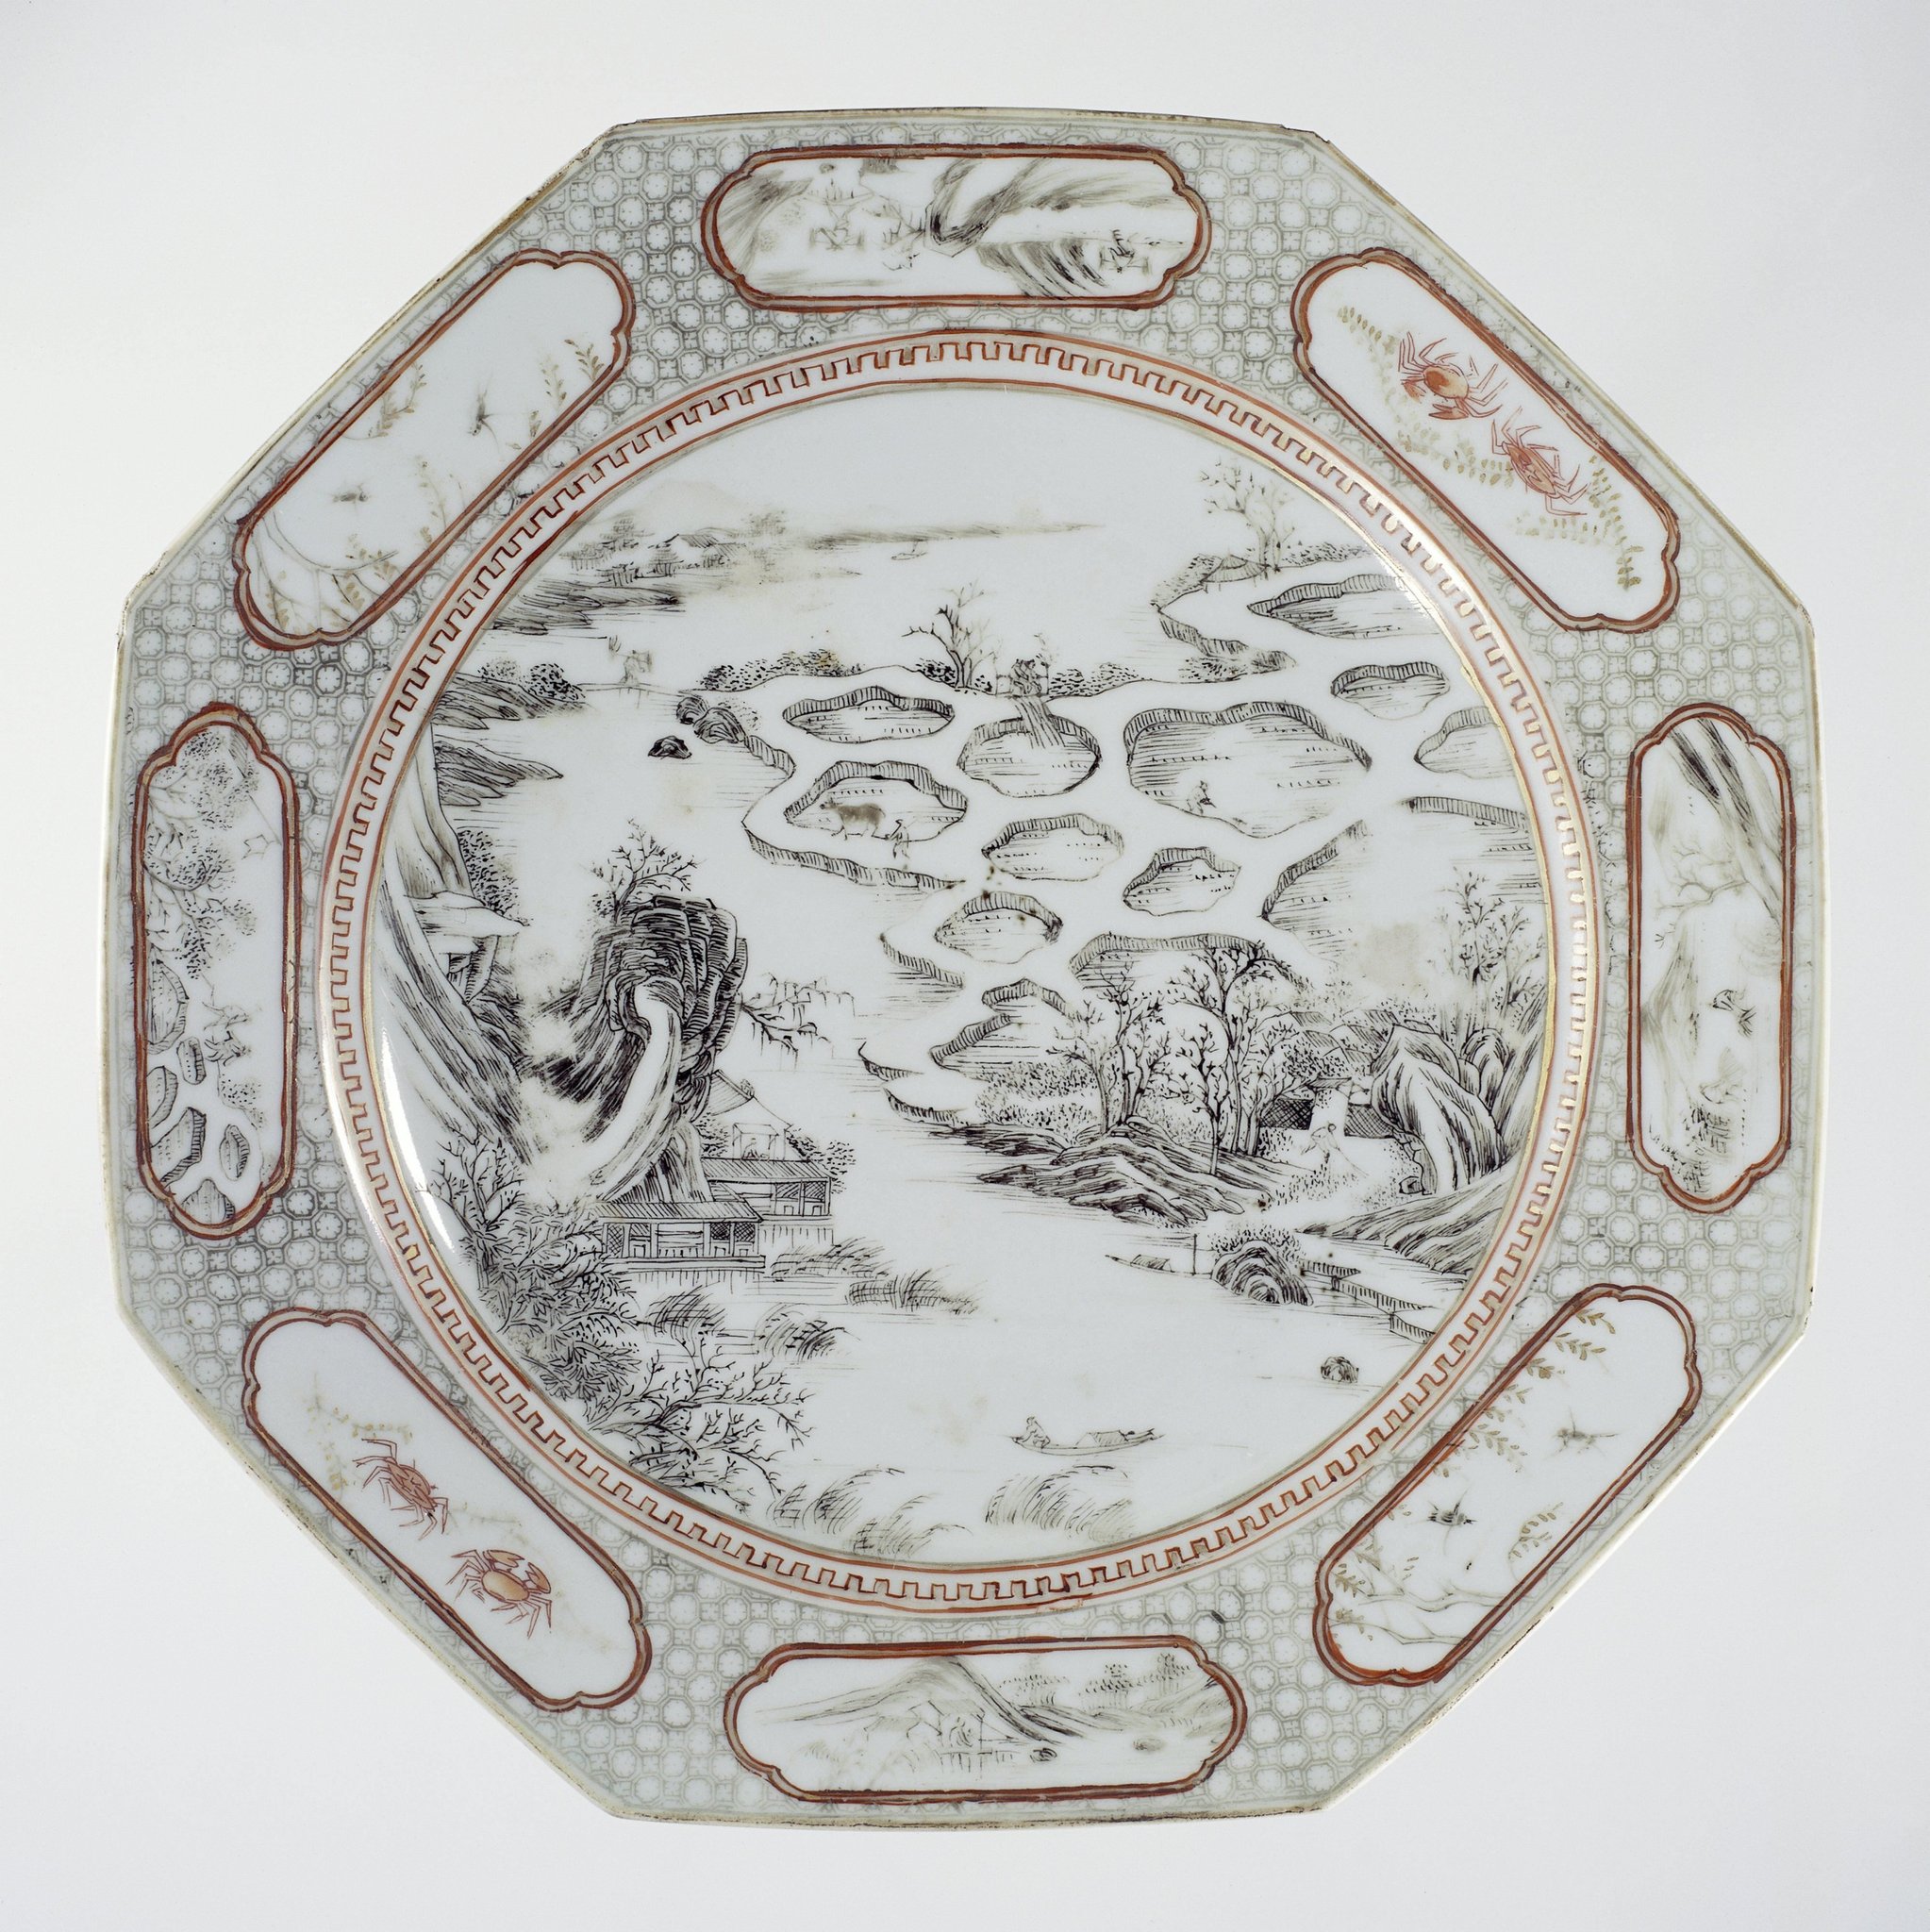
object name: plate dish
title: Octagonal plate with a water landscape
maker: Anonymous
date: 1735-1750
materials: glaze, gold, paint, porcelain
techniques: firing, forming, gilding, turning, vitrification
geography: china